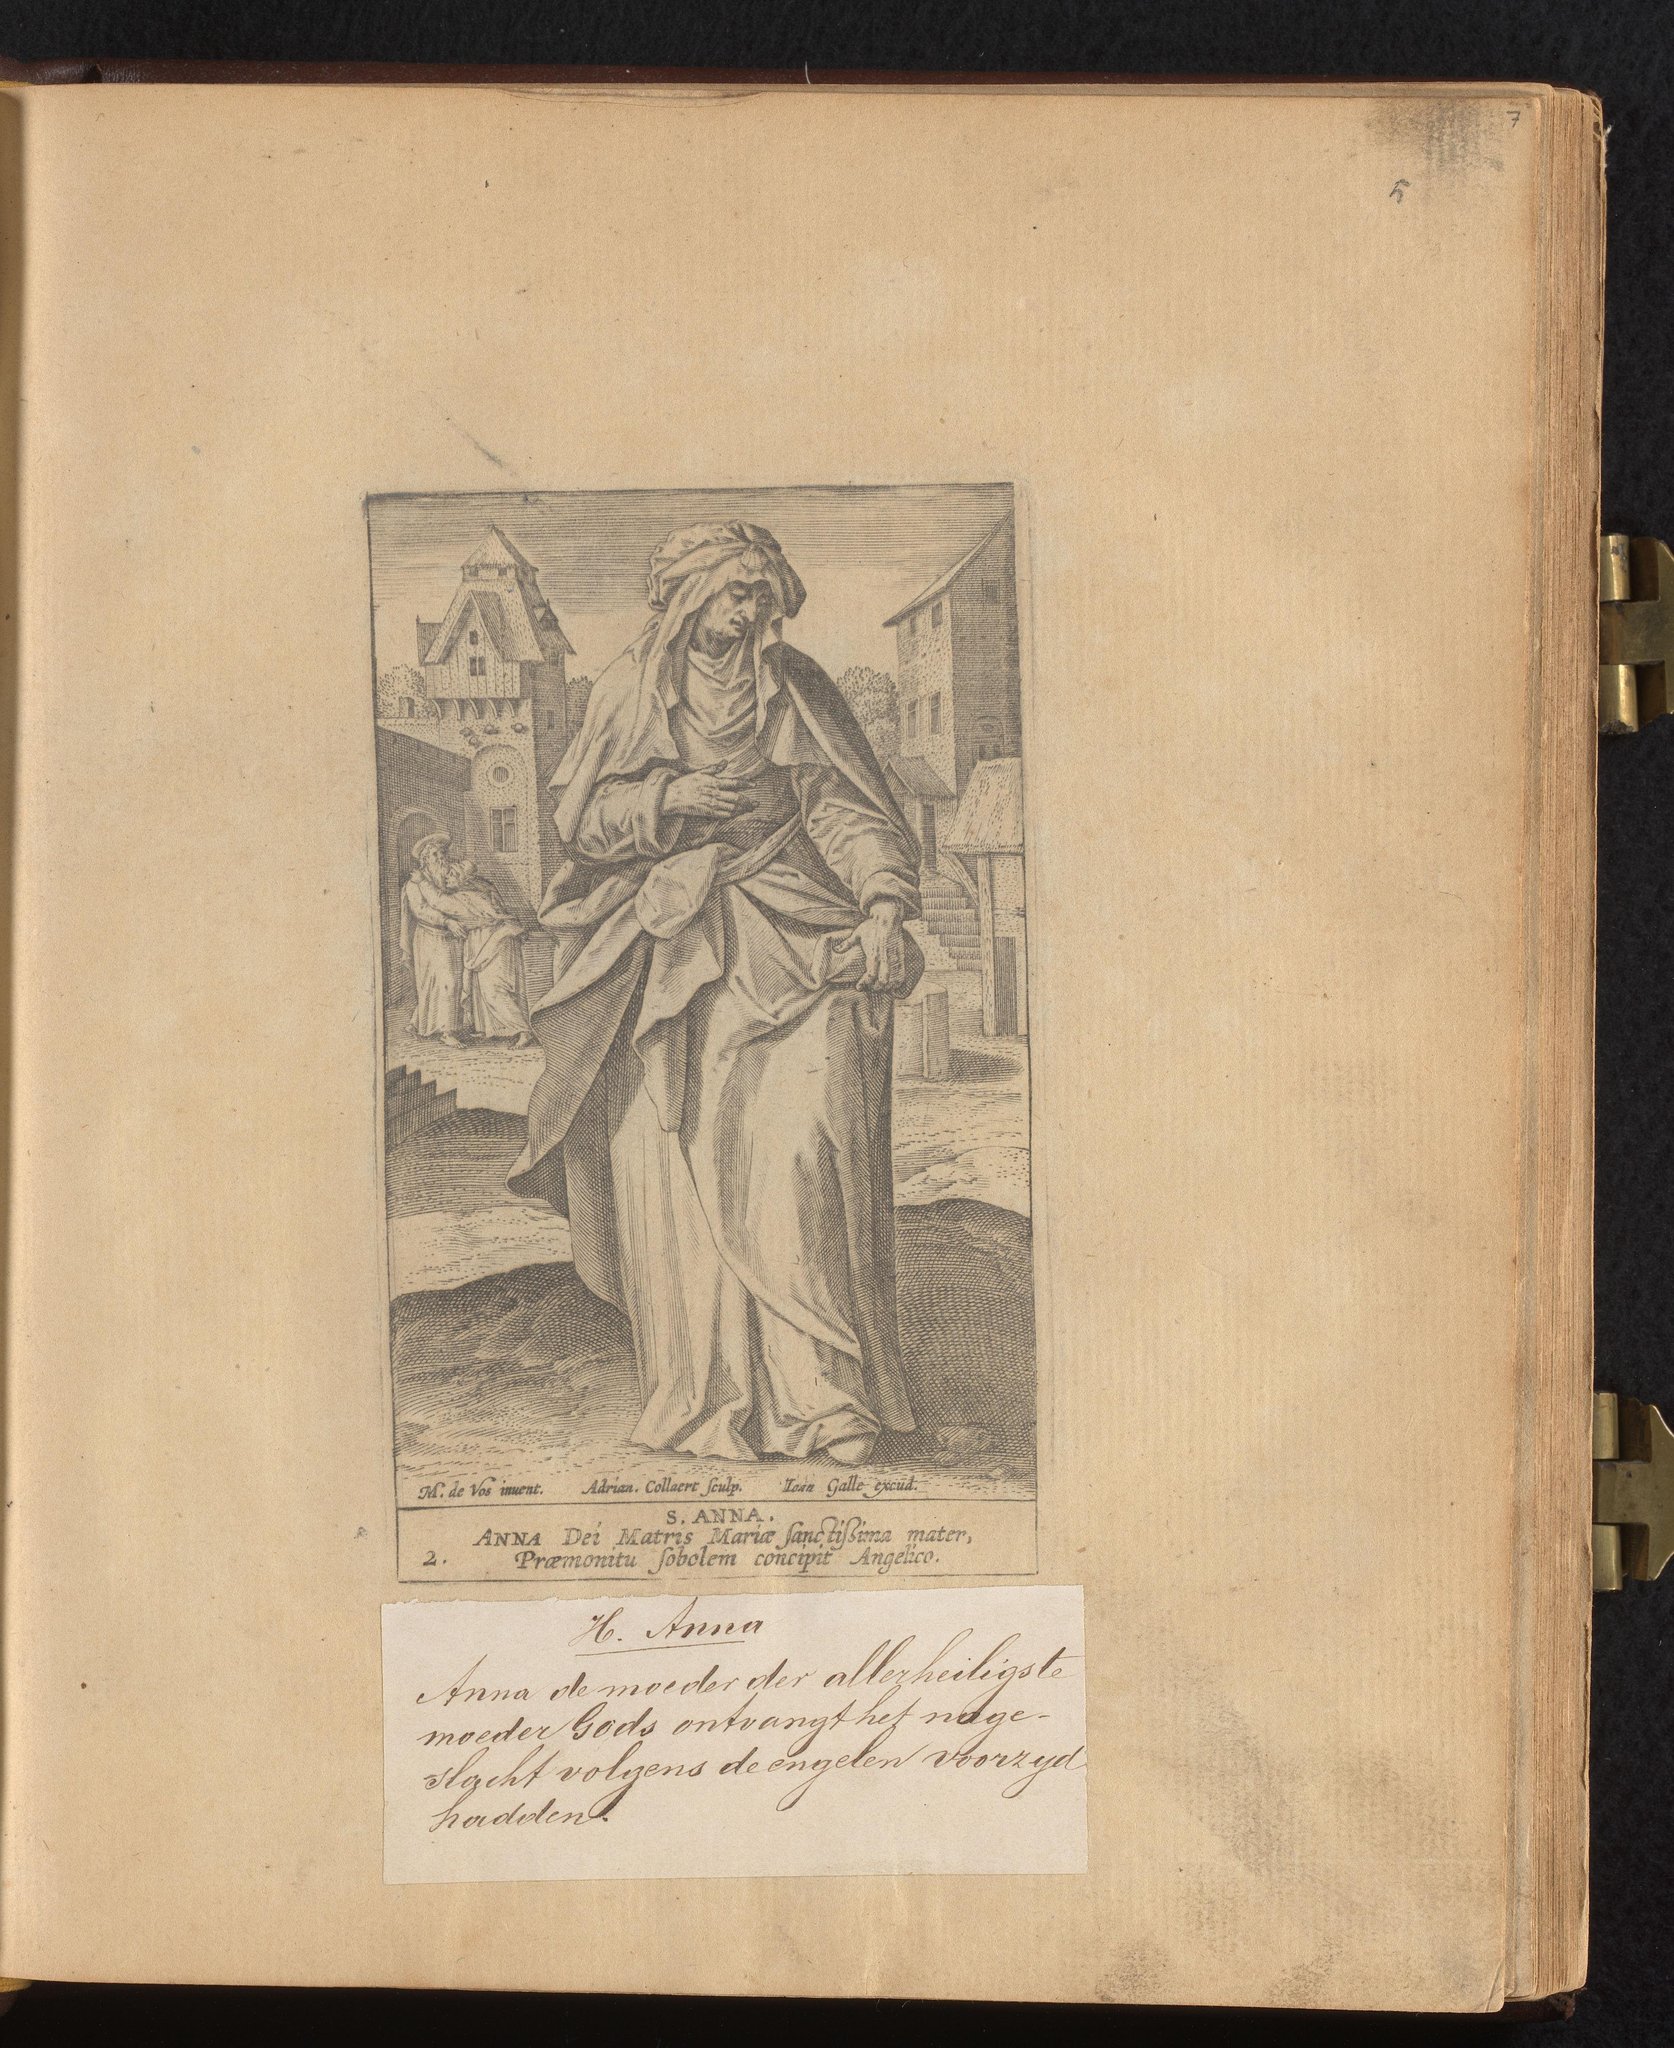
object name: print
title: Icones Illvstrivm Feminarvm Novi Testamenti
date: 1783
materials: paper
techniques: engraving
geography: antwerp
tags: meeting of anna and joachim at the golden gate; they usually embrace or kiss each other (immaculate conception of mary), anna, mother of mary; possible attributes: book, christ-child, lily, virgin mary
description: Prent in: s.n. Aldernouwkeurigste verhandelinge der geschiedenissen van het Nieuw Testament (...). Antwerpen: Cornelis Marten Spanoghe, 1783, p. 16-17.